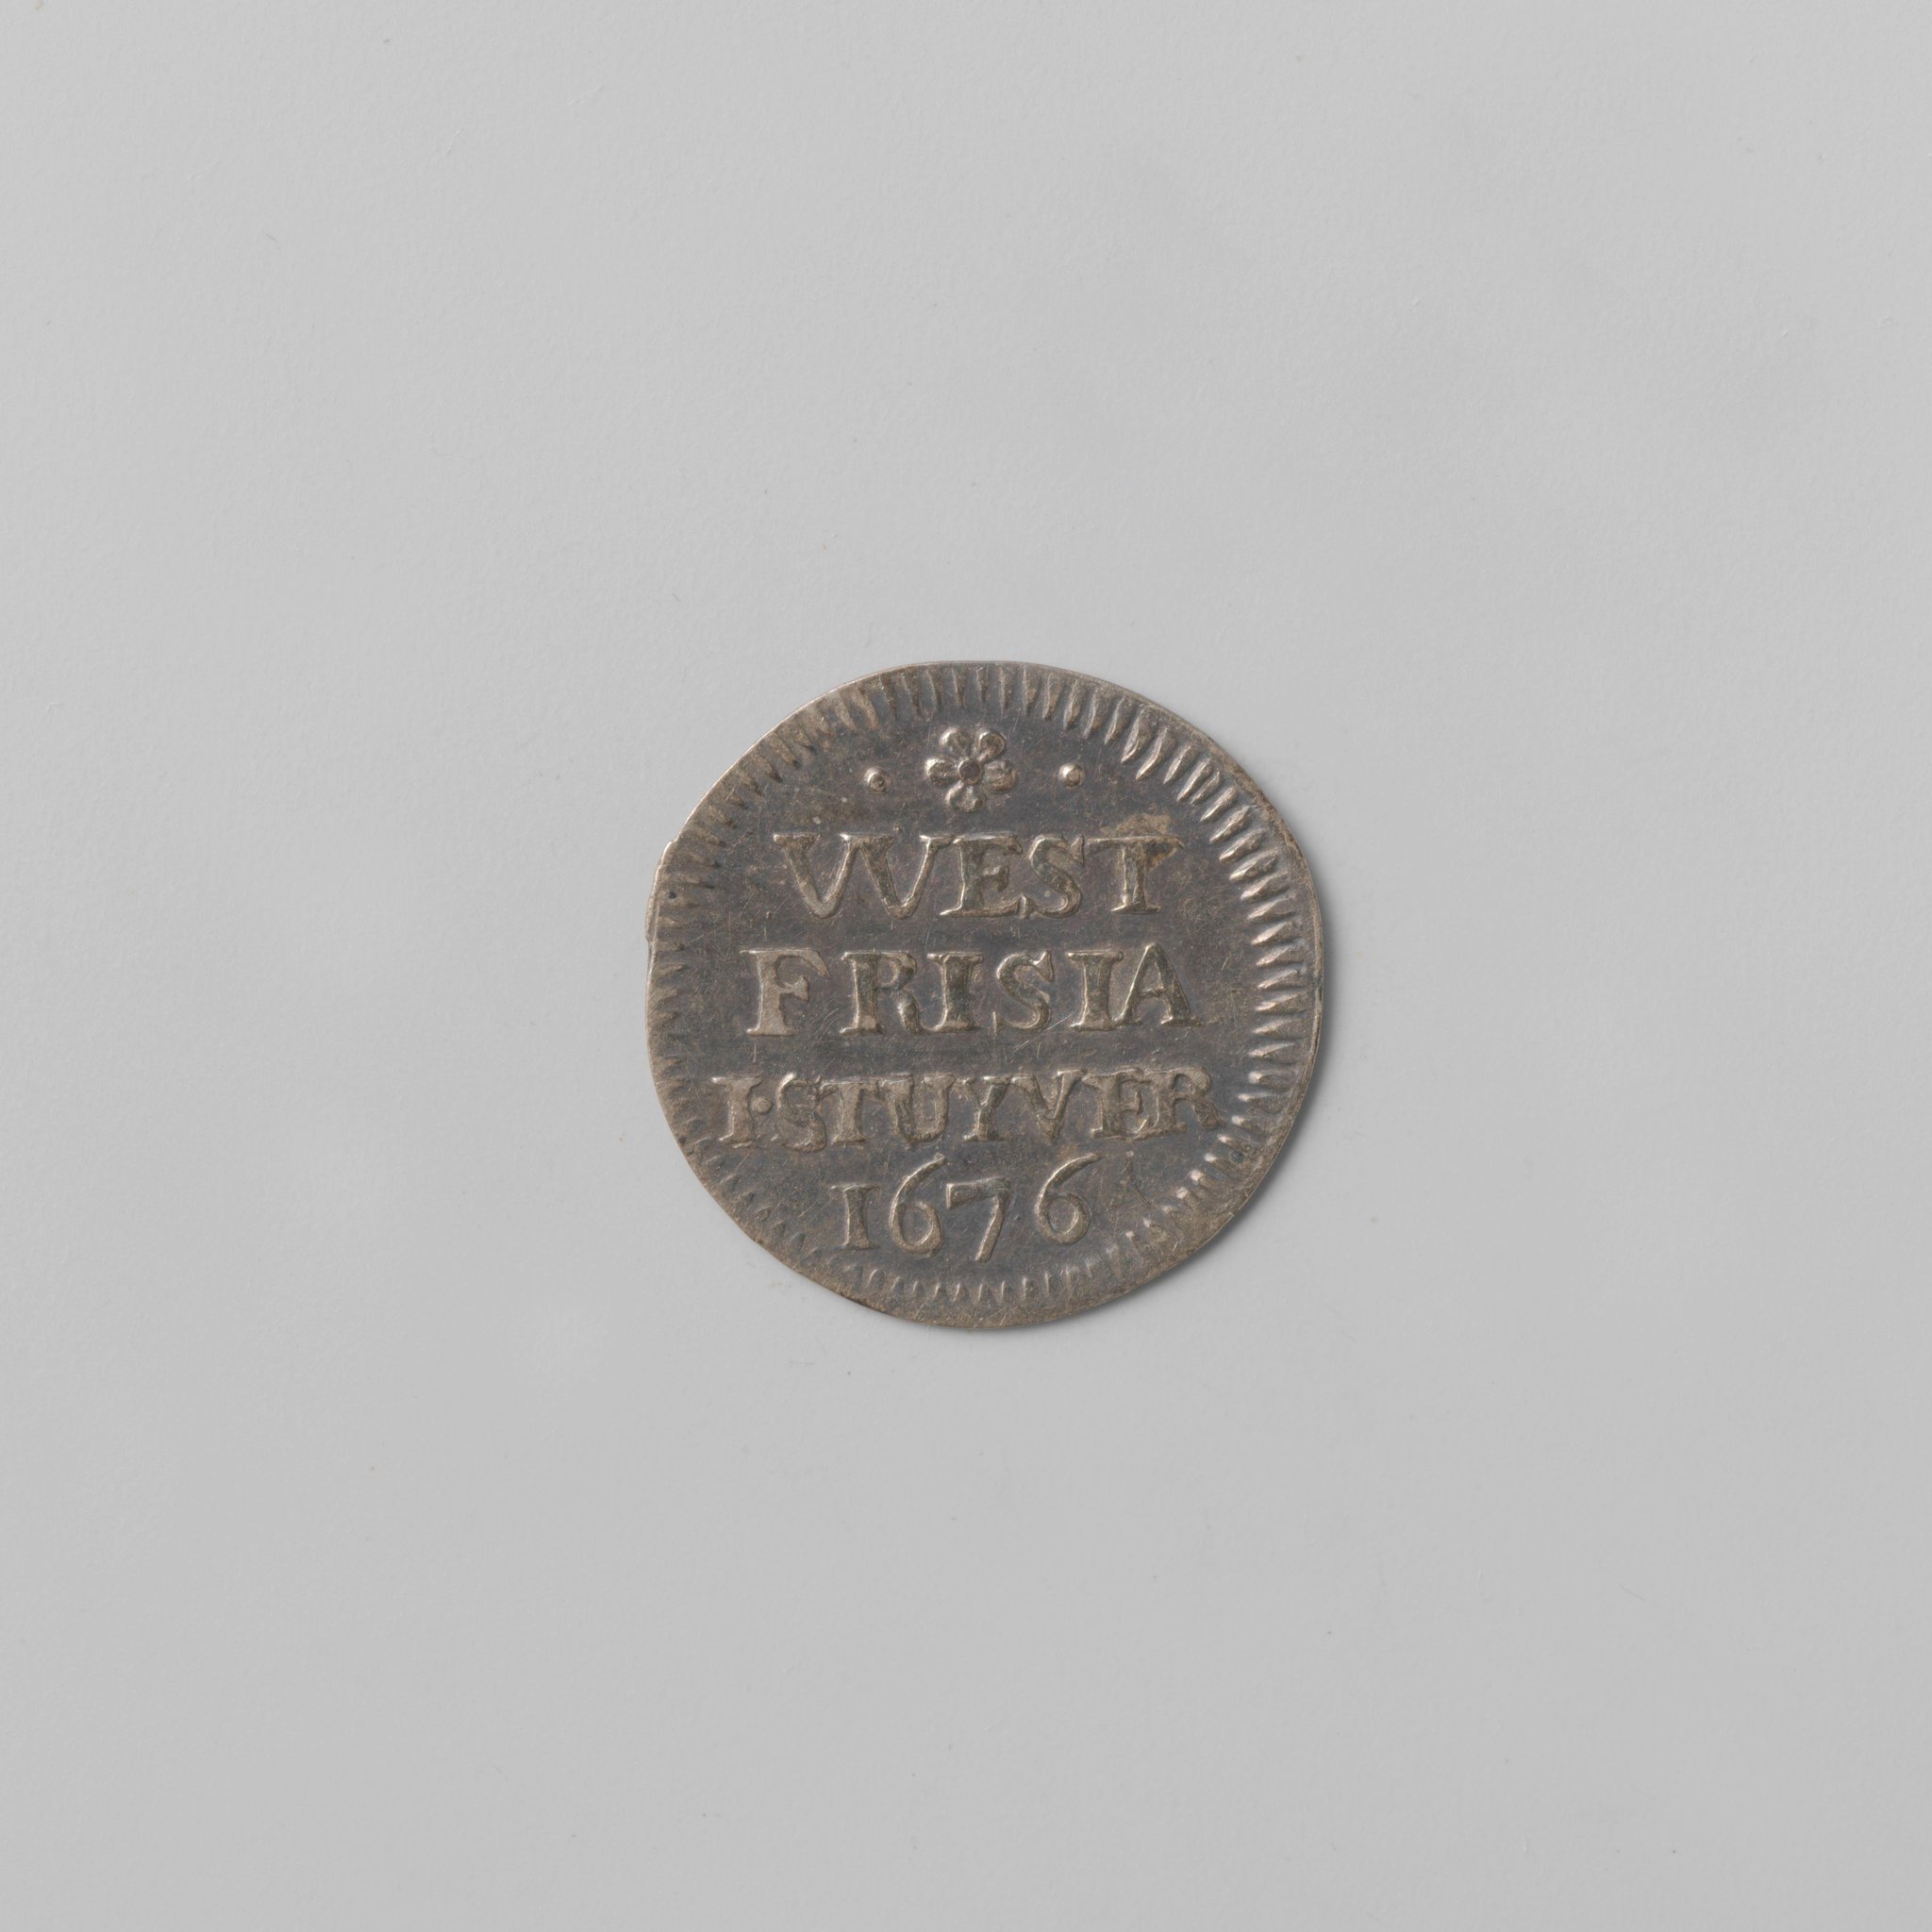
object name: coin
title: Westfriese stuiver, 1676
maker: dirck bosch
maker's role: mintmaster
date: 1676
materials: silver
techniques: striking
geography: enkhuizen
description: Zilveren munt. Voorzijde: tussen letters B en P gekroond wapenschild van West-Friesland. Keerzijde: Opschrift in twee regels.Daaronder waarde-aanduiding en jaartal. Daarboven een rozet tussen twee punten.